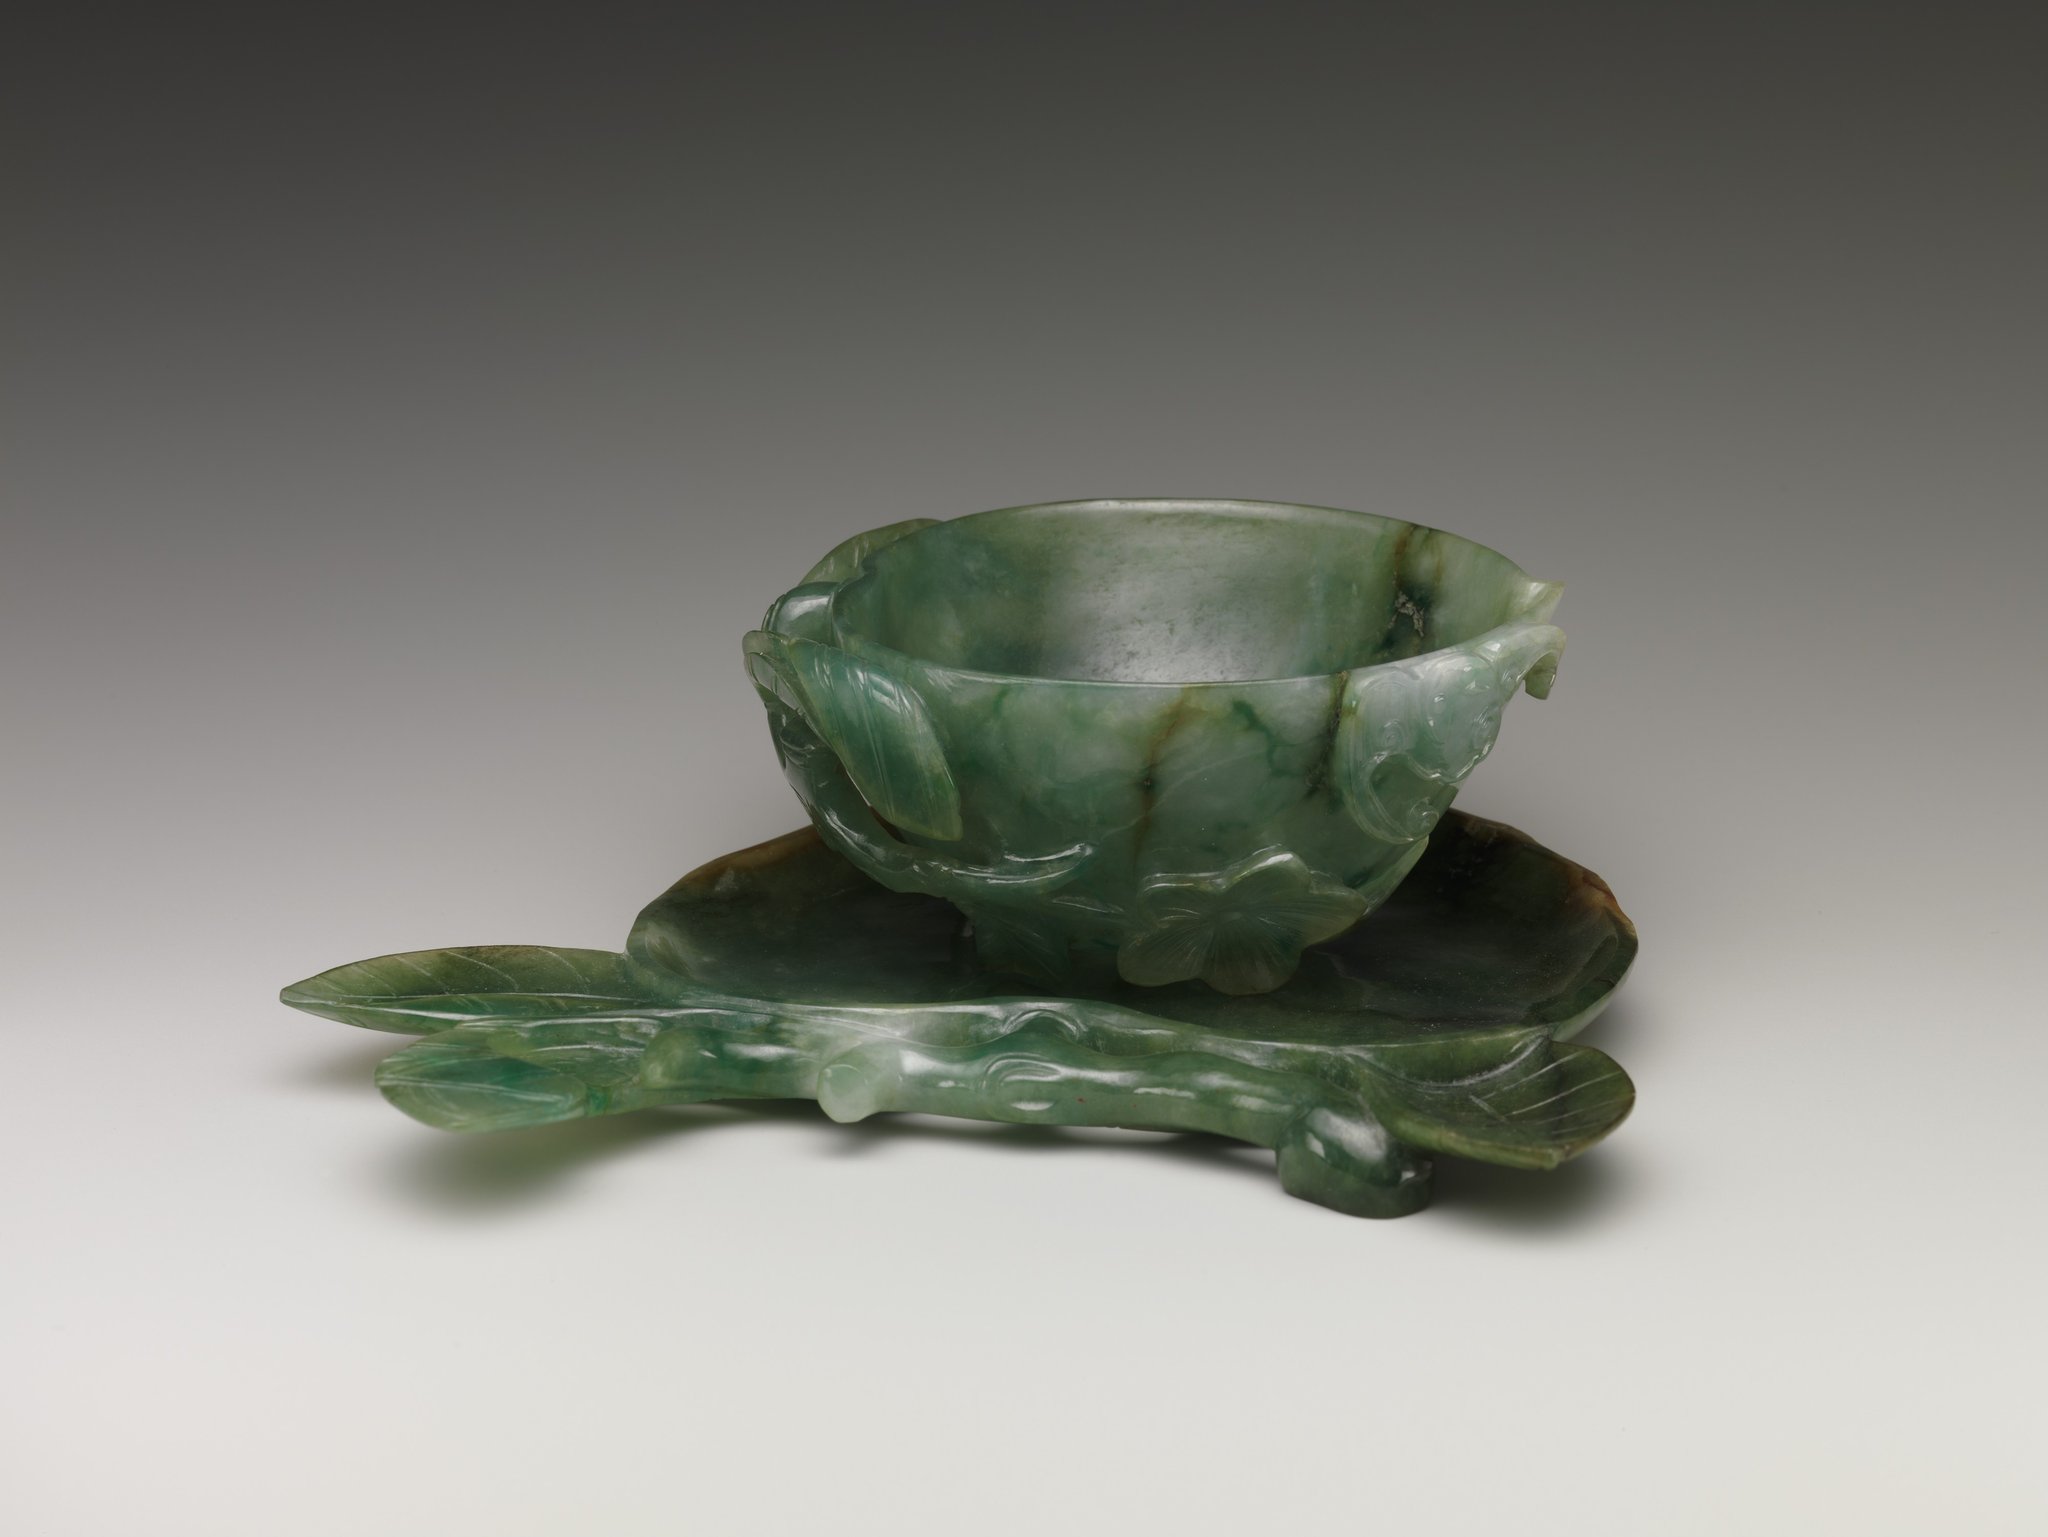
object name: cup and saucer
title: Peach-shaped Cup with Saucer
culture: chinese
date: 1801-1900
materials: jade